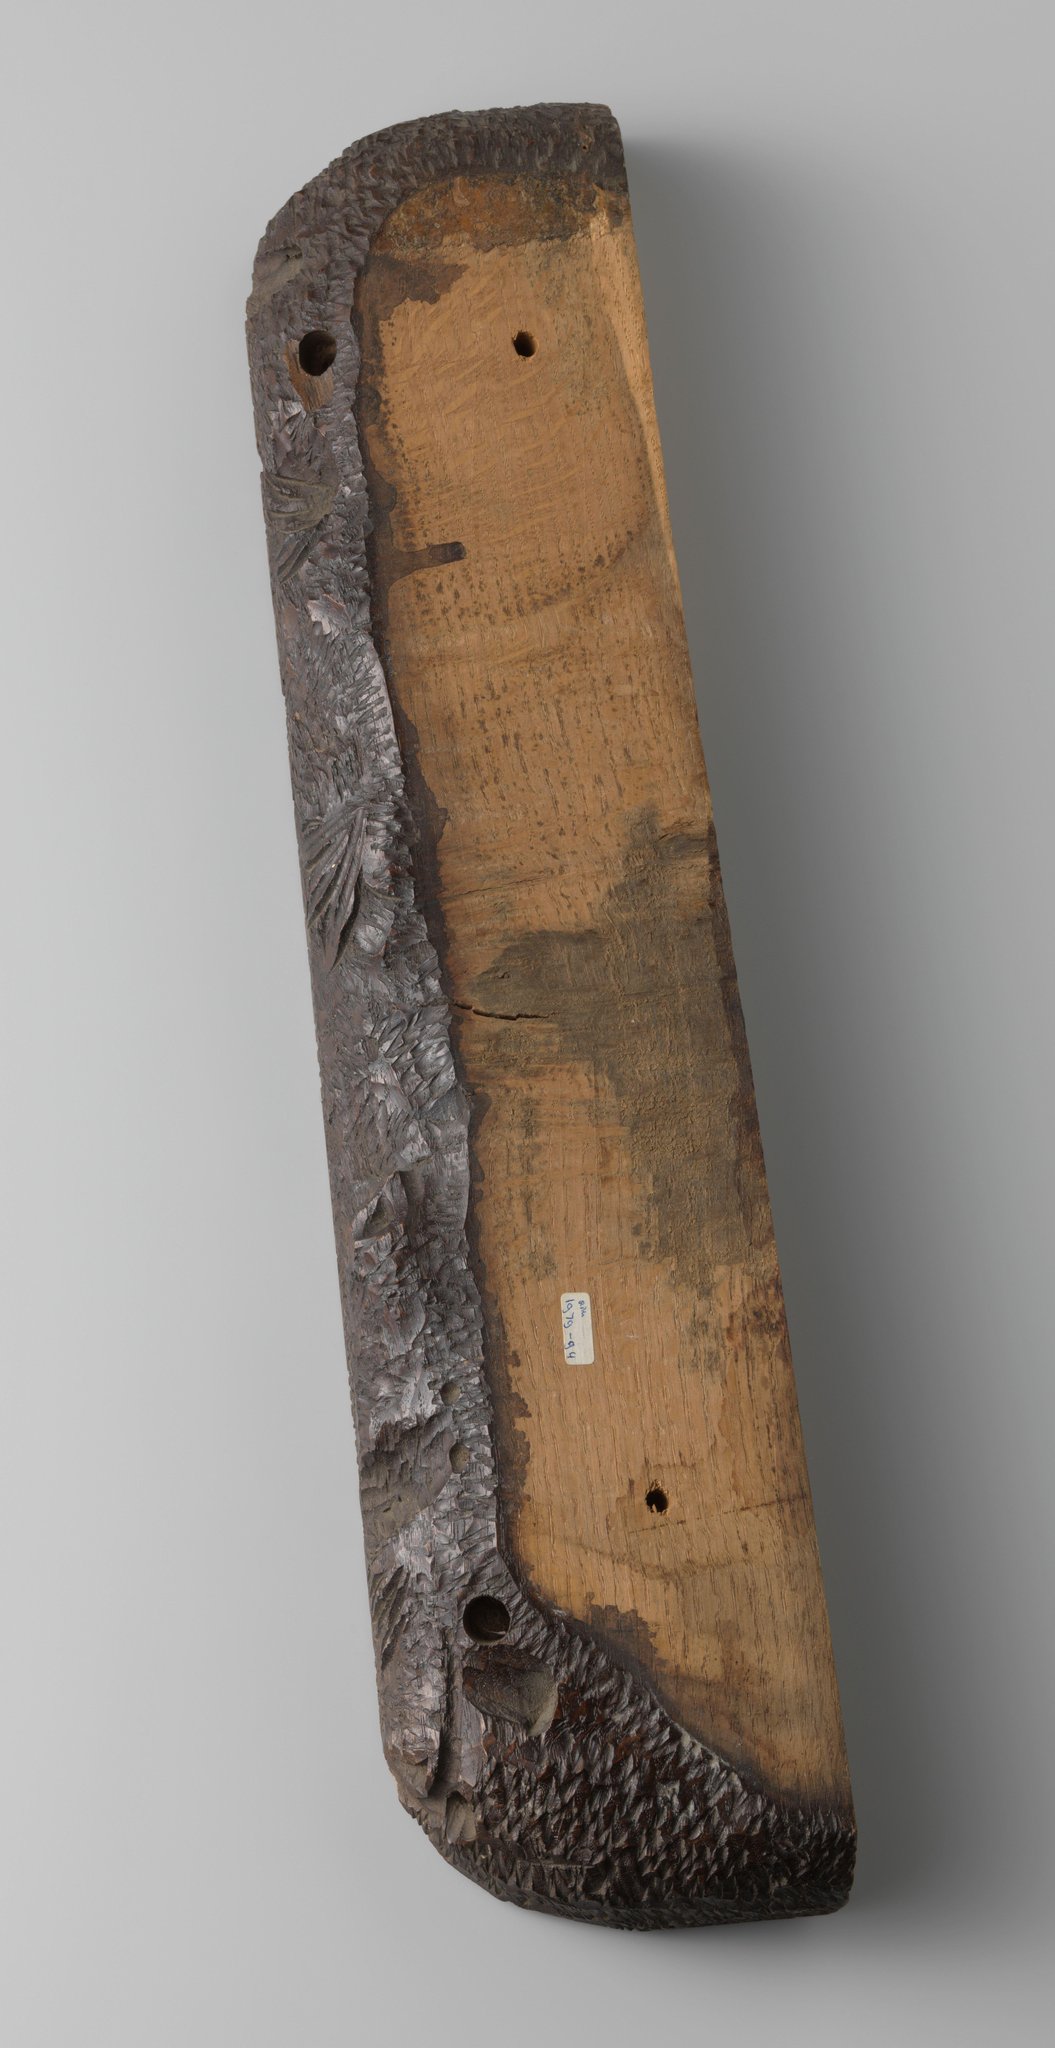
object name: sculpture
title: Plint van de Kruisiging:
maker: adriaen van wesel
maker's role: sculptor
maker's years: 1415-1490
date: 1475-1477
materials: wood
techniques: gilding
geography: utrecht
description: Waarschijnlijk later toegevoegde plint, na restauratie verwijderd.